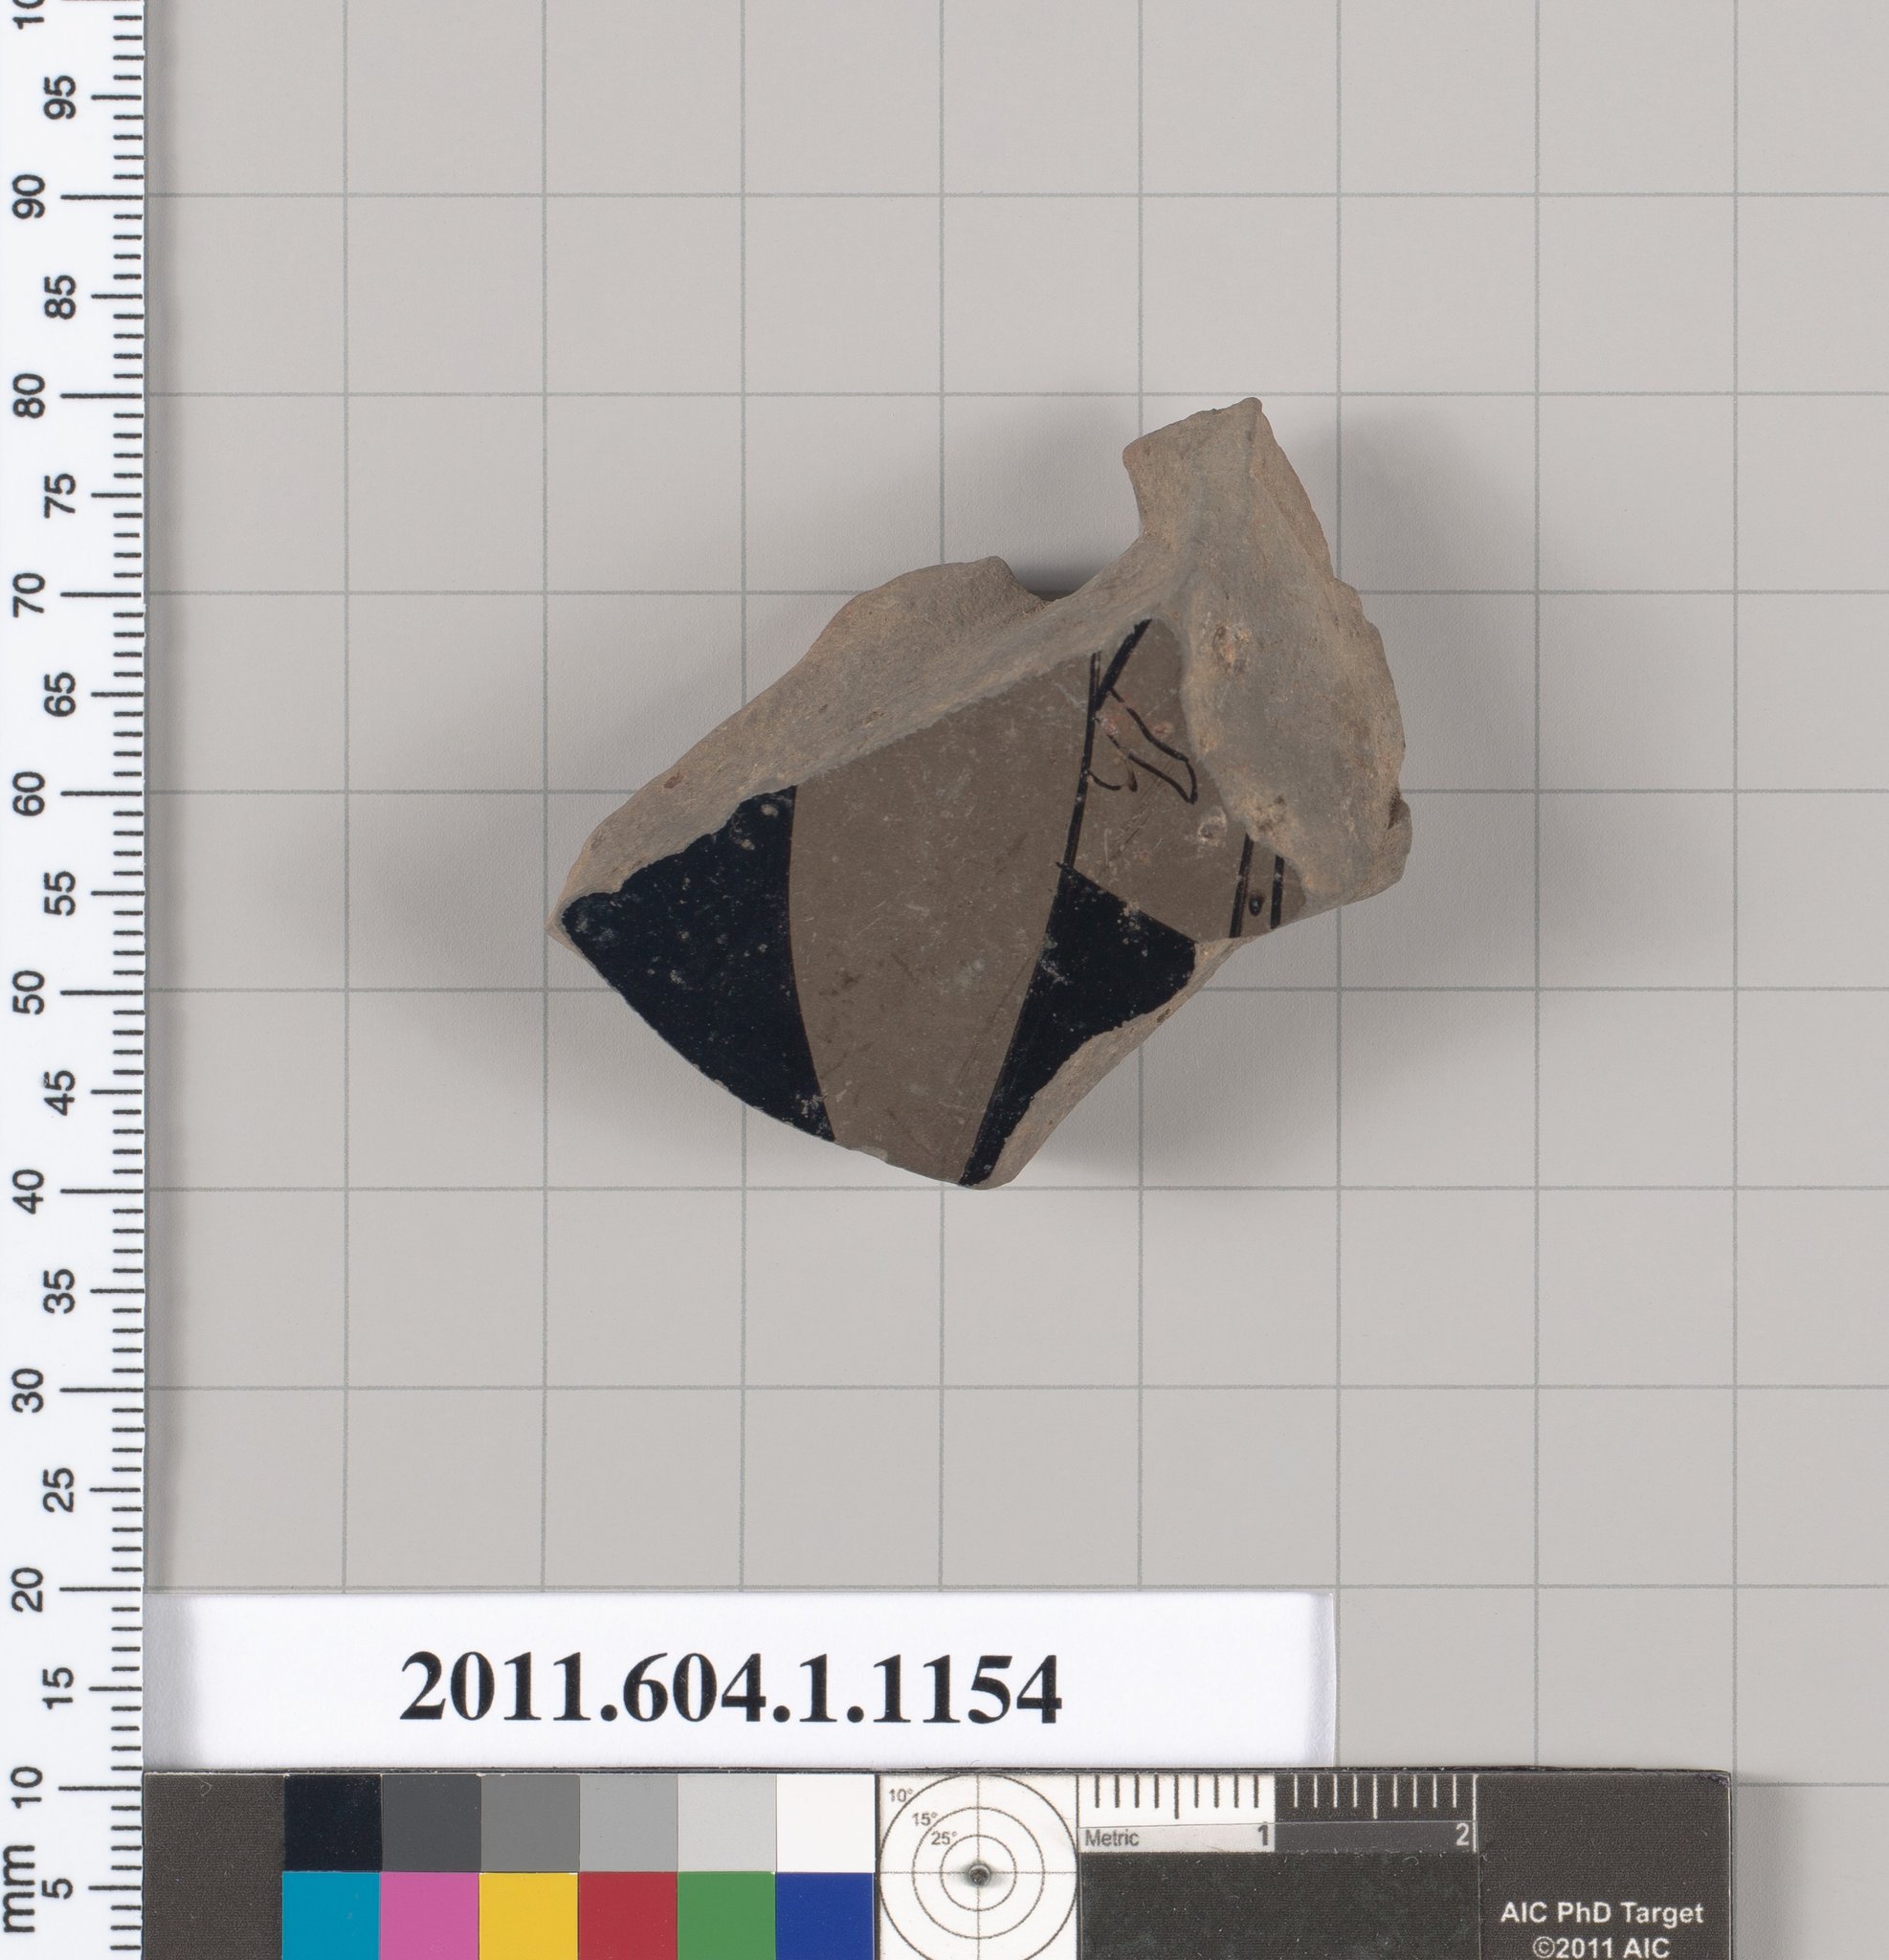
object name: kylix fragment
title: Terracotta fragment of a kylix (drinking cup)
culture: greek, attic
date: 490-480 BCE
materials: terracotta